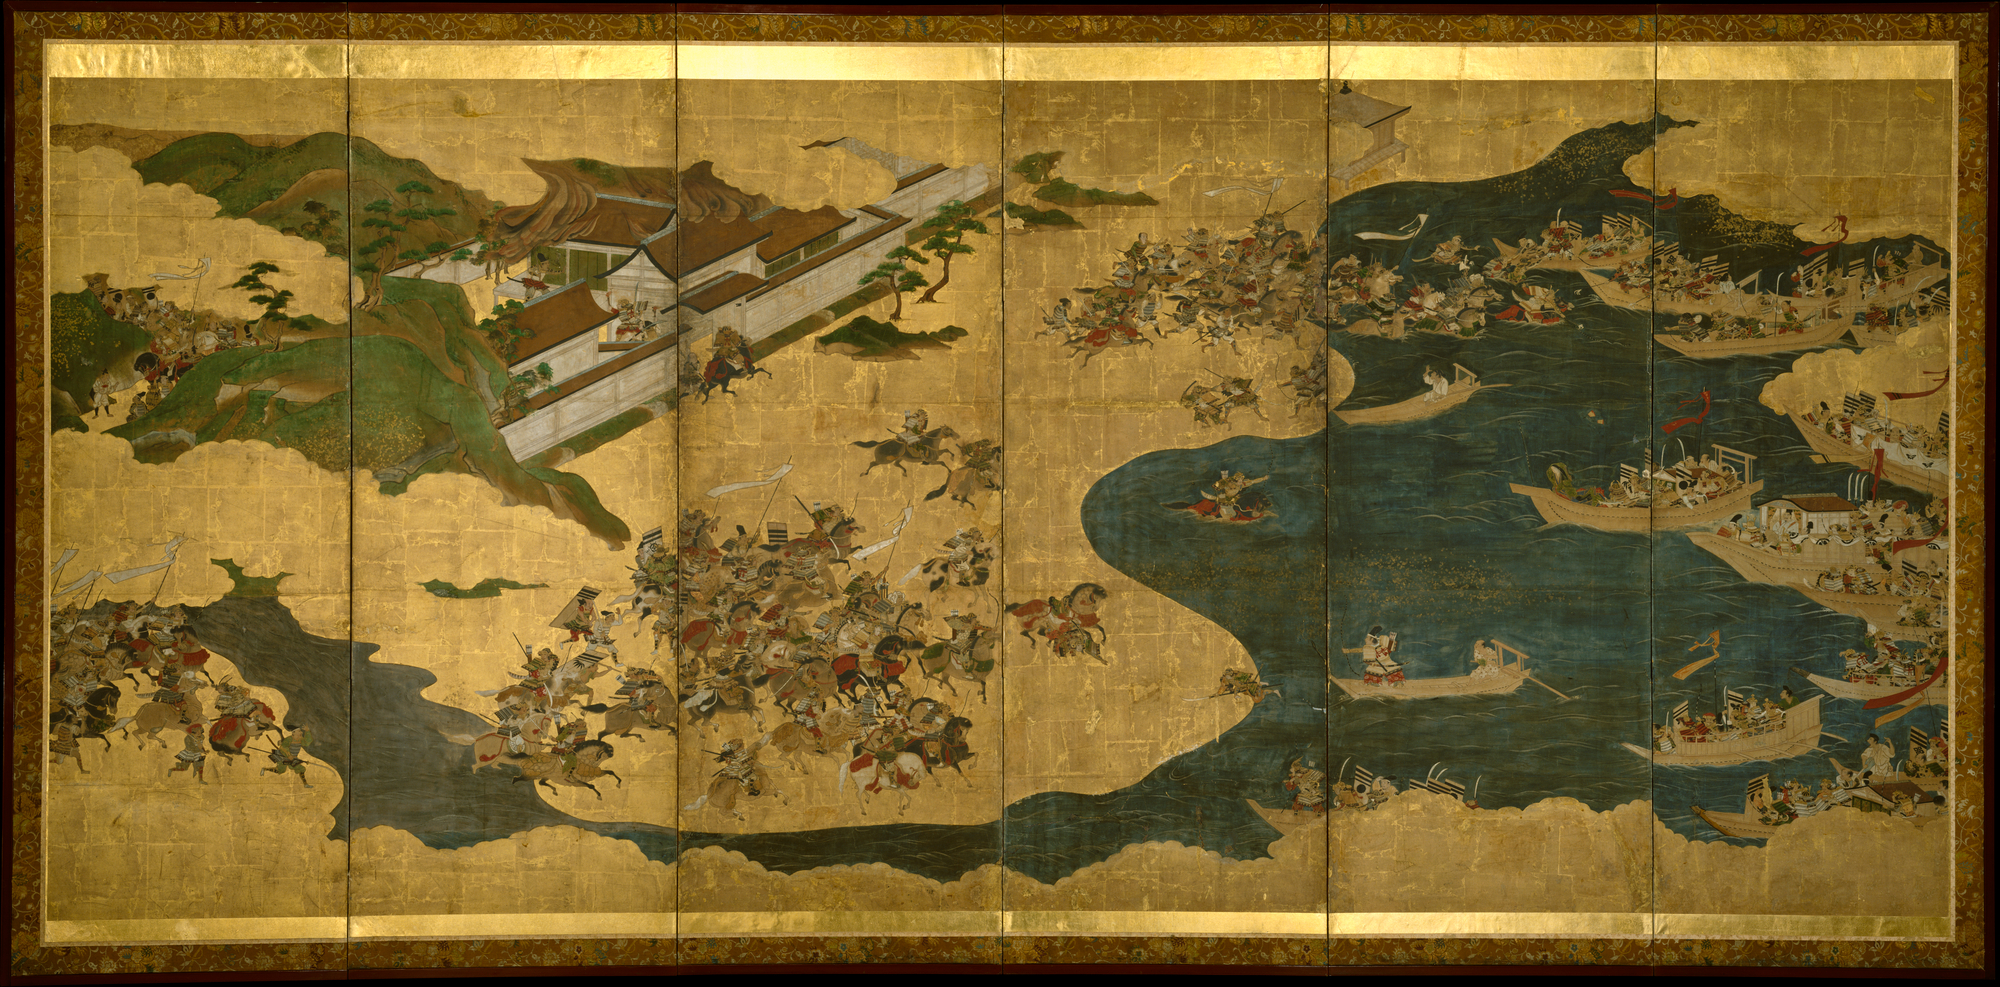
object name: screen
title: The Battle of Yashima, from The Tale of the Heike (Heike monogatari)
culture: japanese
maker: tosa school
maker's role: artist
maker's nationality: japanese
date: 1601-1700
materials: gold, gold leaf, ink, panel, paper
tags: battles